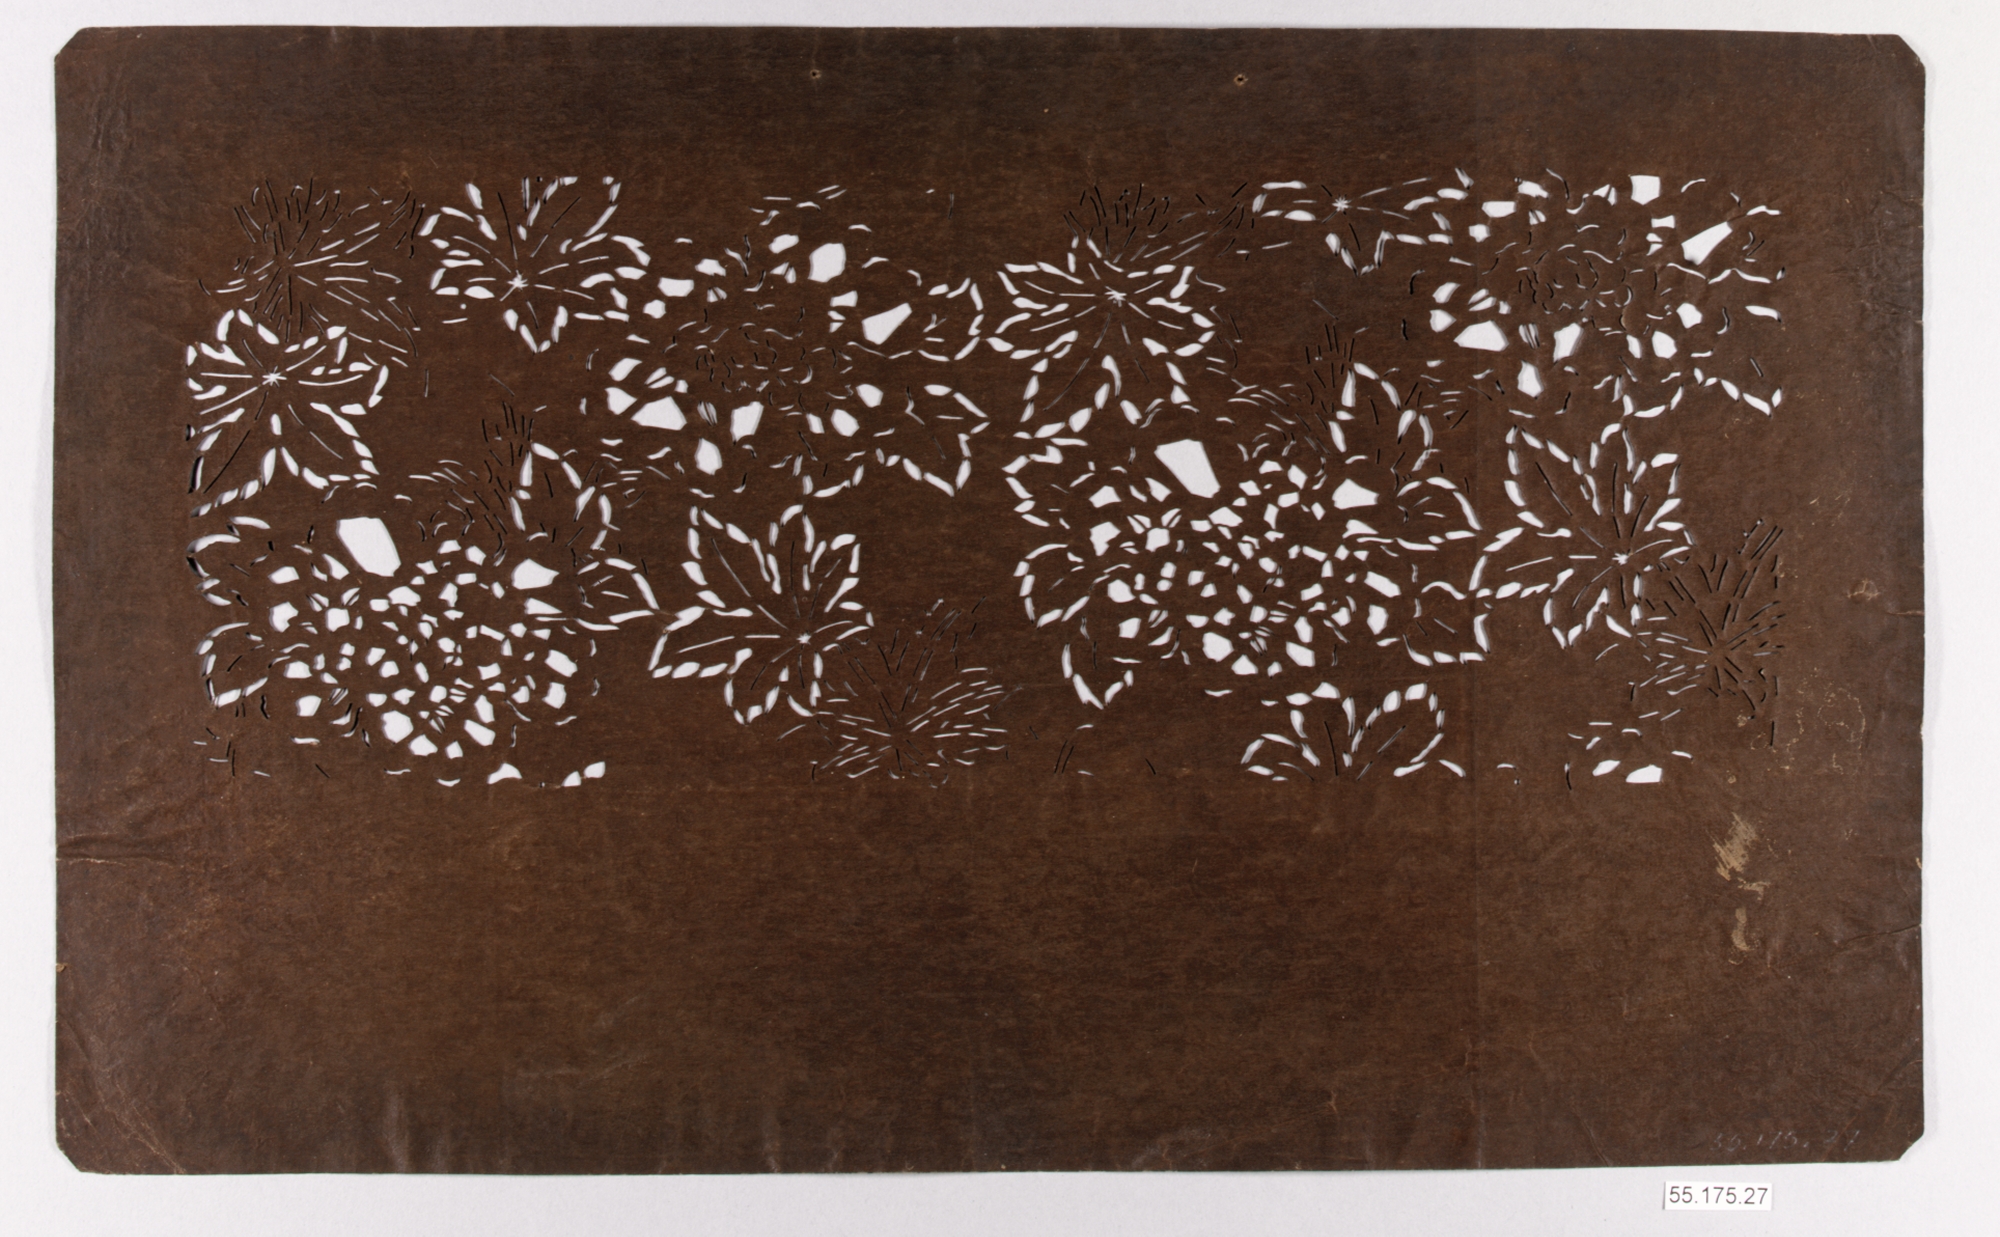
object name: stencil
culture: japanese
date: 1801-1900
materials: paper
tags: flowers